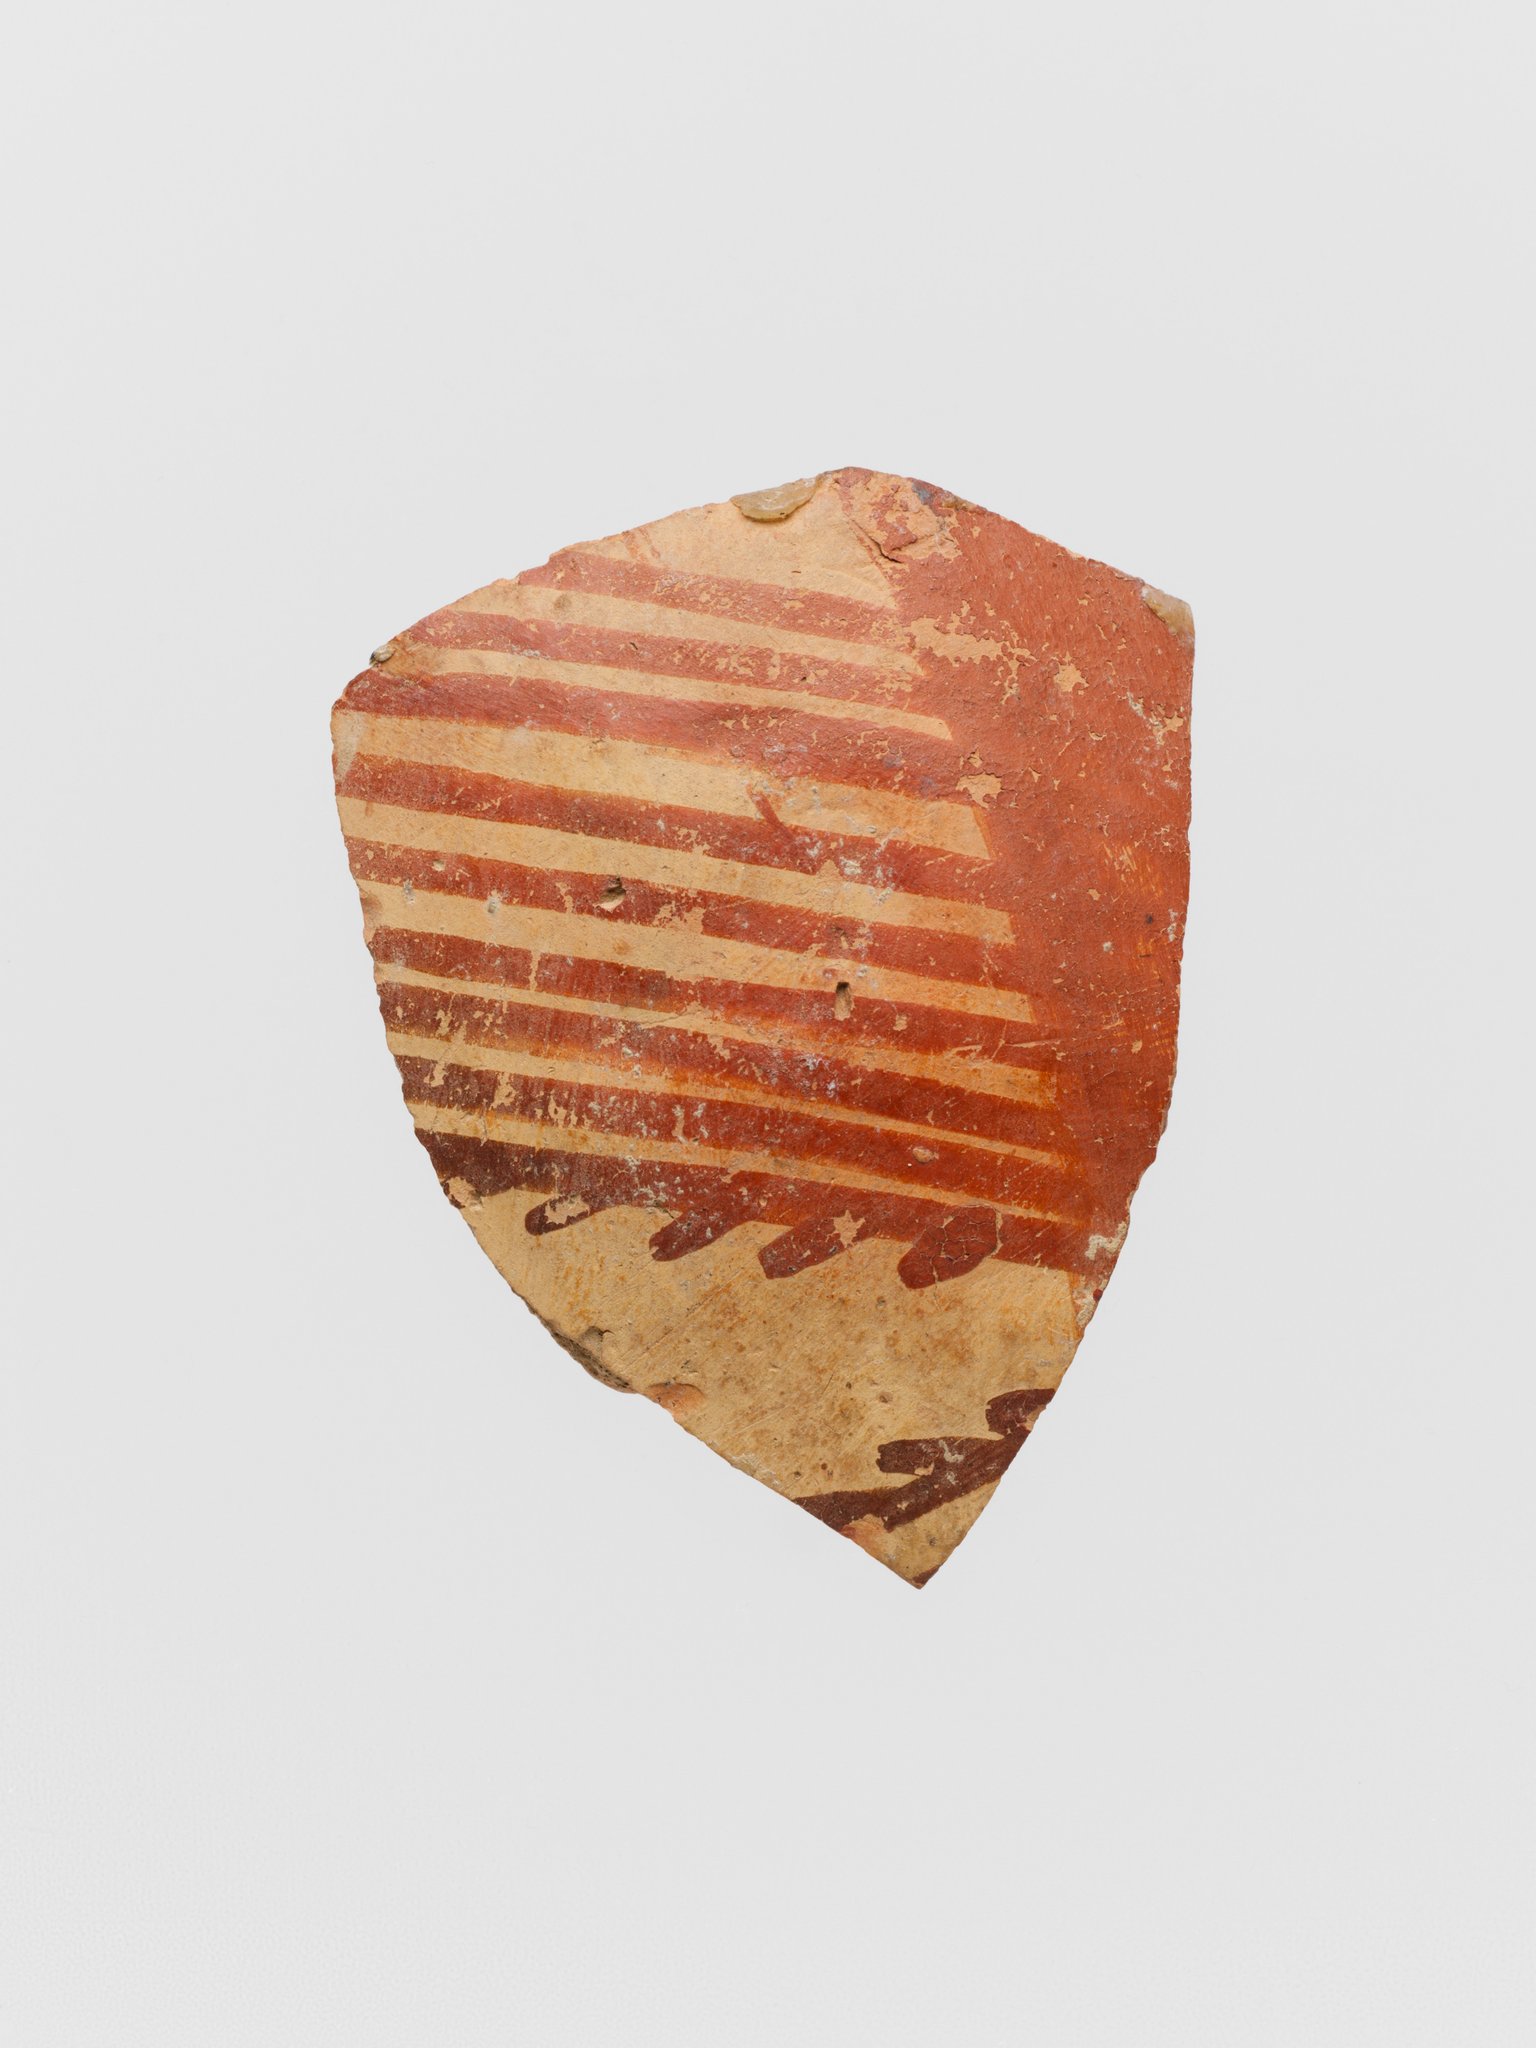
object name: vase fragment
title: Terracotta vessel fragment with linear motifs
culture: helladic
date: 2600-2300 BCE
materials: terracotta